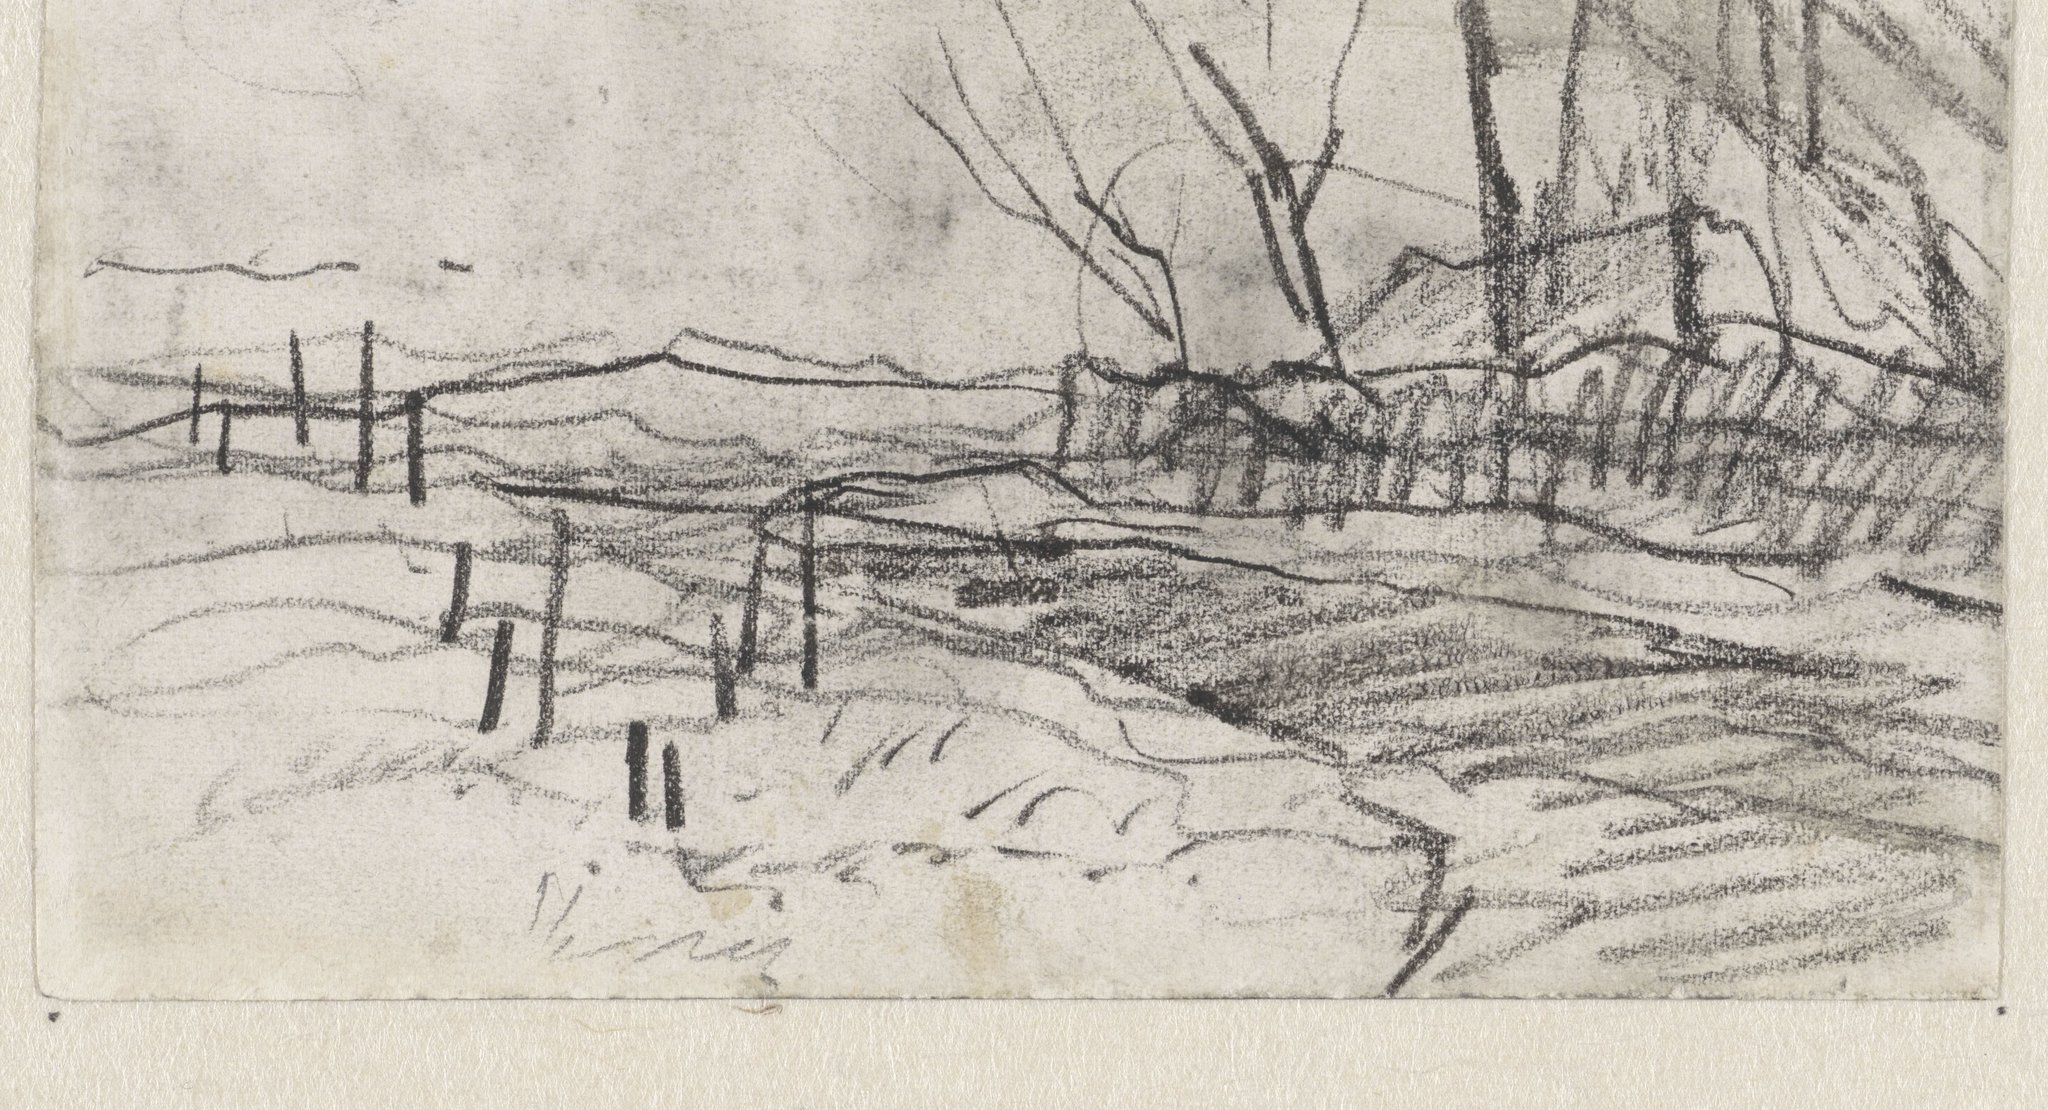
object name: drawing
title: Landschap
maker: anton mauve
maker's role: draughtsman, painter, print maker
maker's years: 1838-1888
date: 1848-1888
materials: chalk, paper